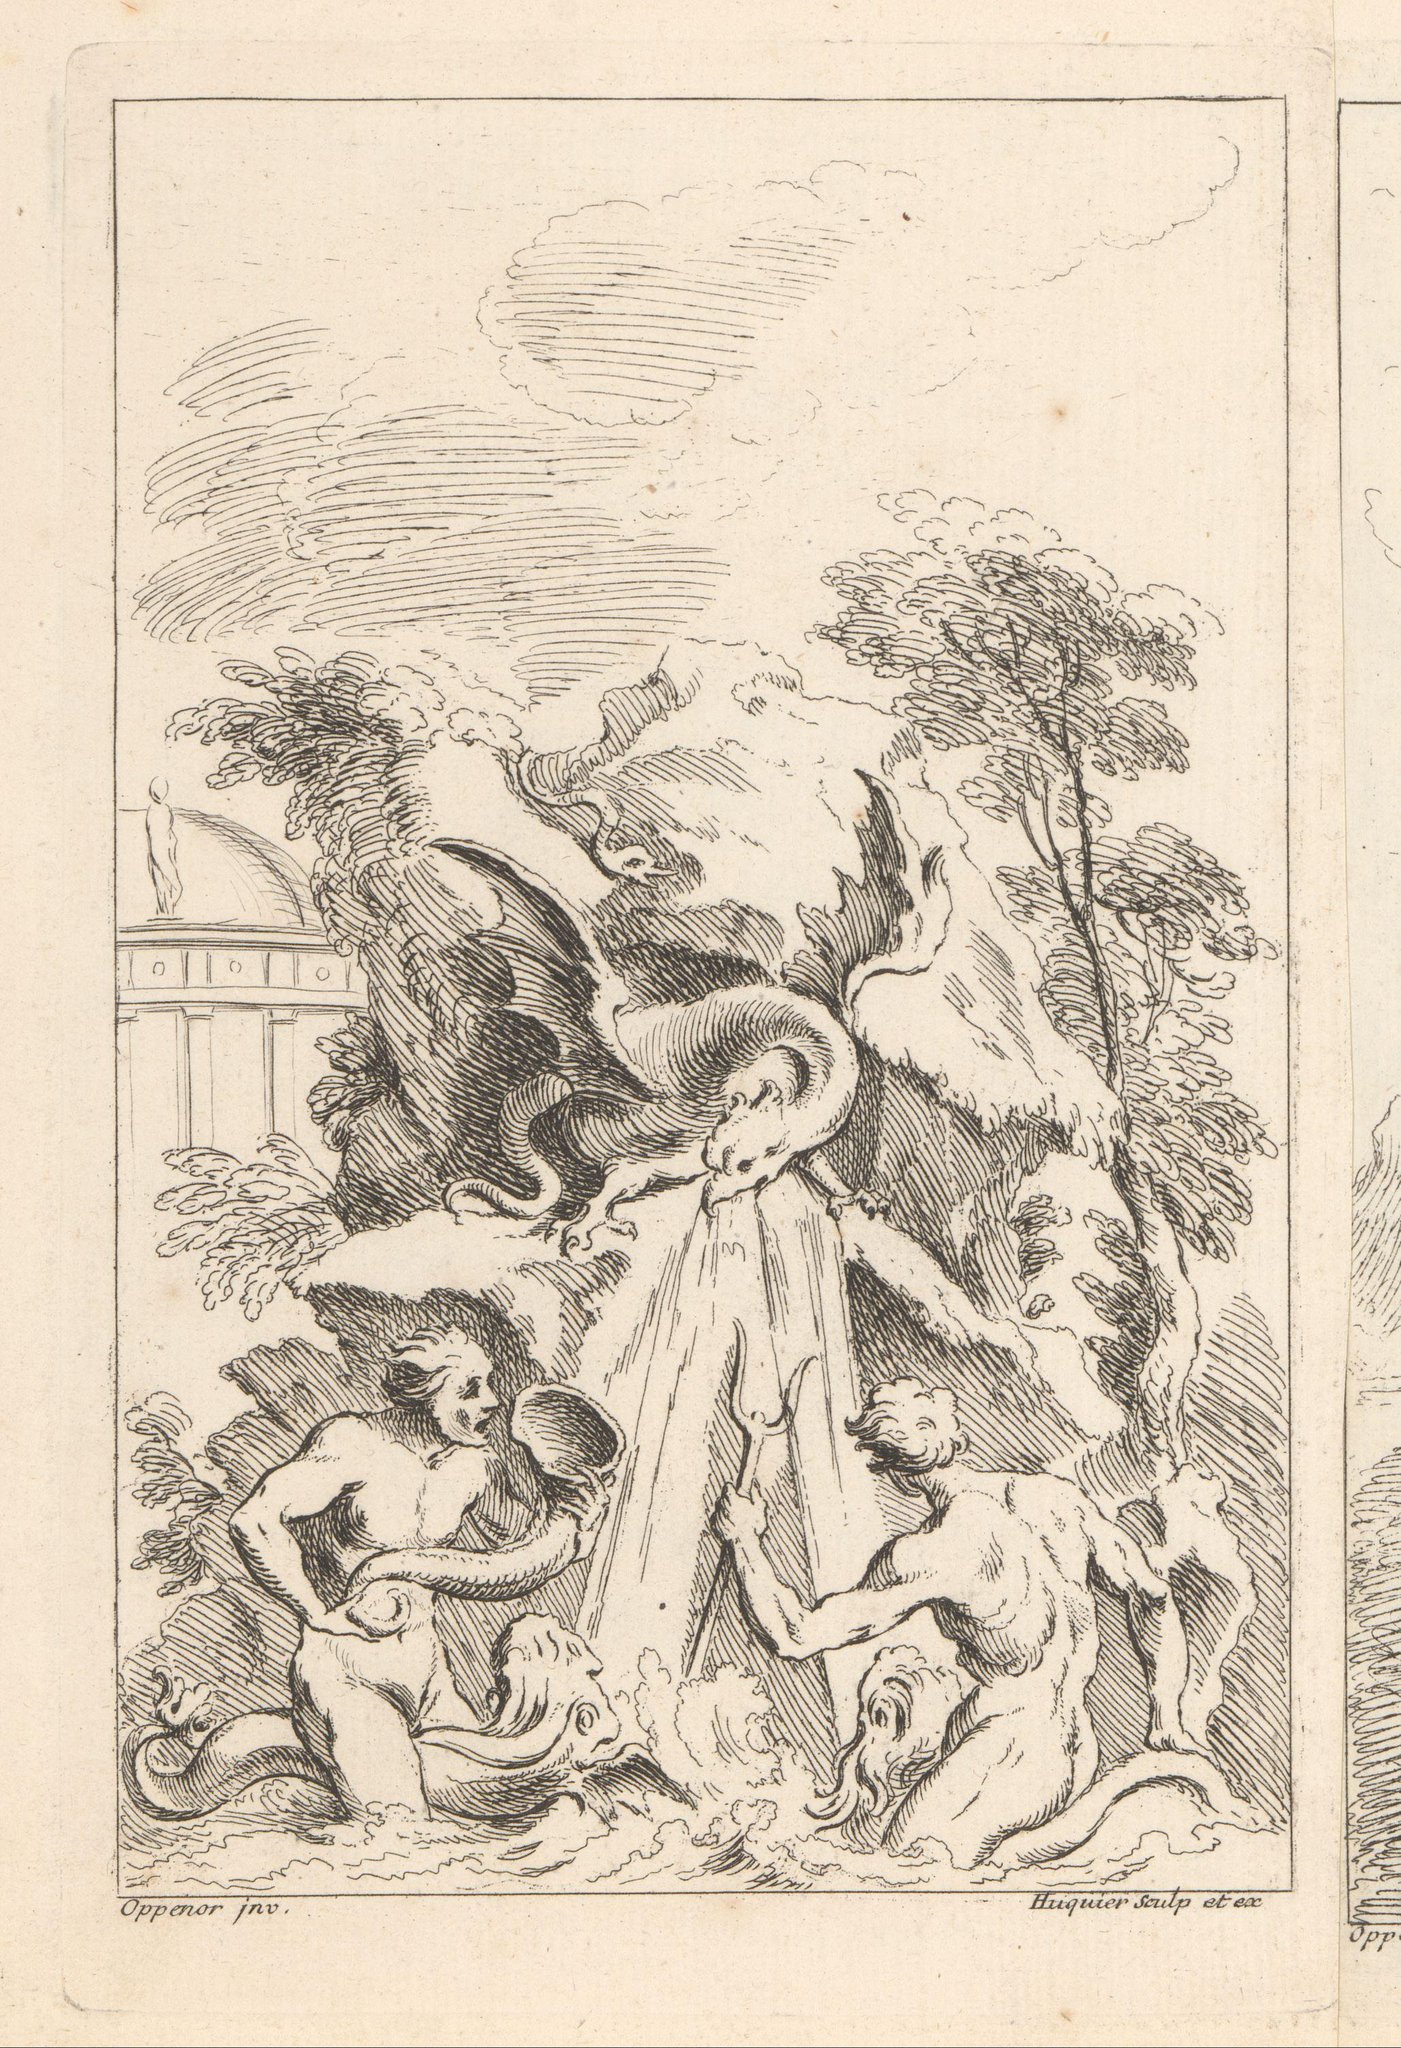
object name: album leaf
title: Nouveau livre de fontaines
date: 1725-1750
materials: paper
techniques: etching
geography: paris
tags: fabulous animals ~ lizards, garden fountain, ornamental fountain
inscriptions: collector's mark: Lugt 2228a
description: De prenten van deze reeks zijn telkens per twee aan elkaar geplakt om in het boek mee te binden met hetzelfde formaat als de voorgaande bladen.